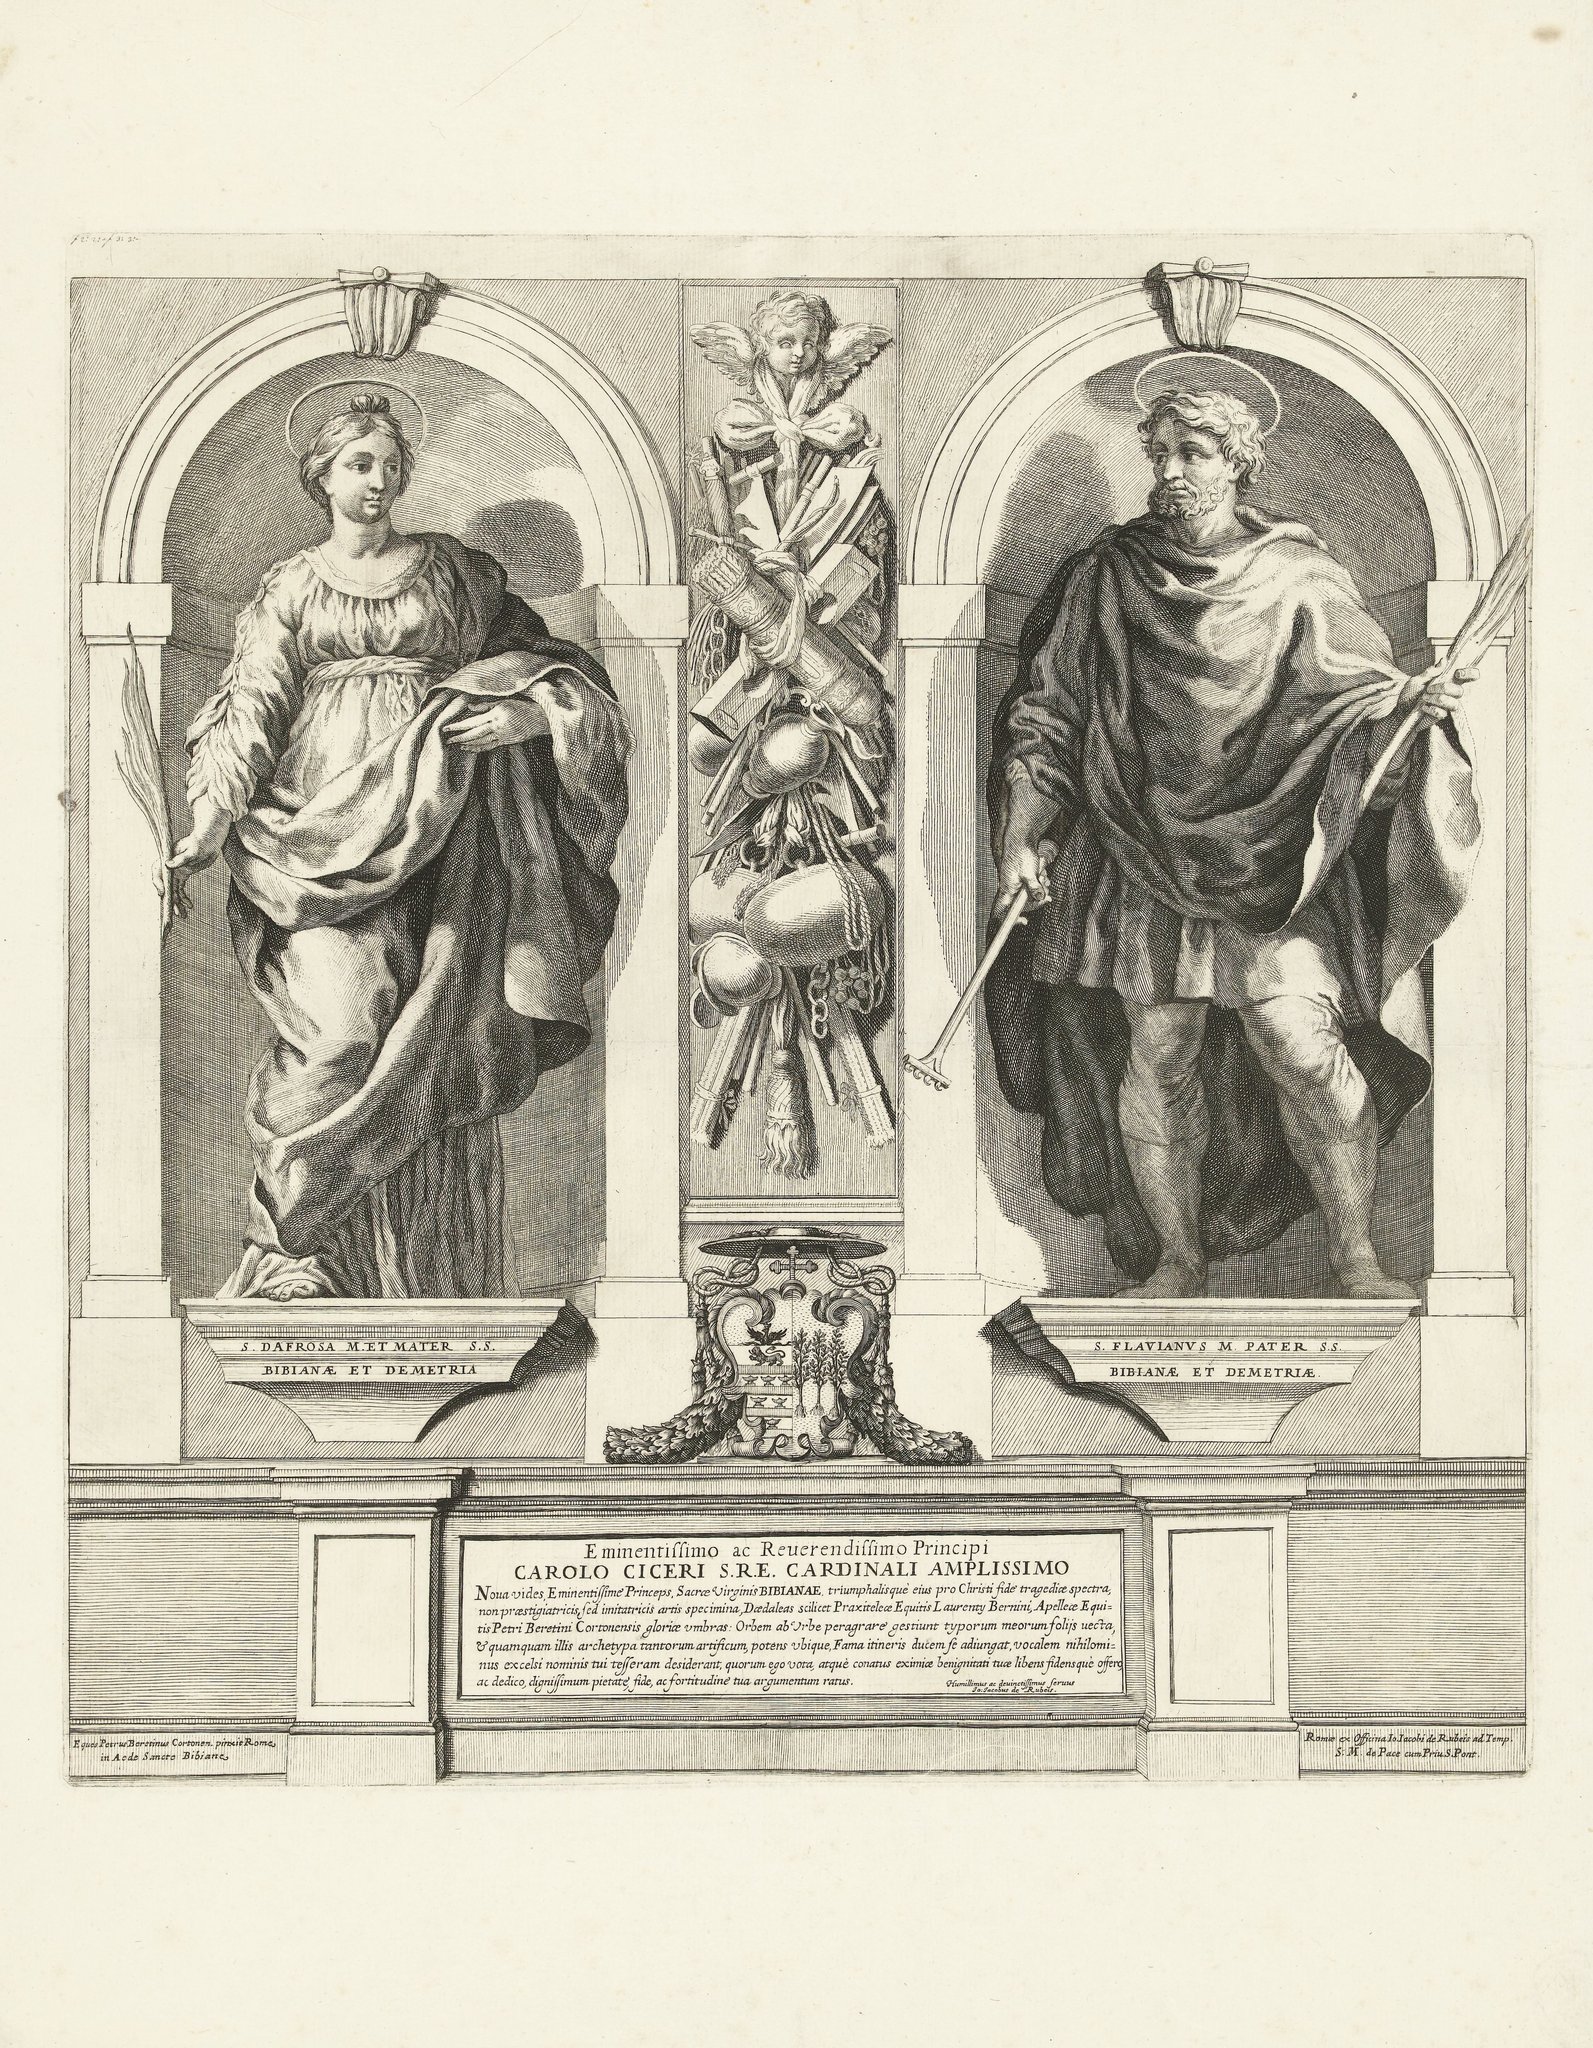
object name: print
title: Schilderingen en beelden uit de kerk Santa Bibiana in Rome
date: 1685-1691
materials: paper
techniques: engraving, etching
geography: rome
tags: female saints (with name), piece of sculpture, reproduction of a piece of sculpture, parents (first degree family relationships)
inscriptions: collector's mark: Lugt 240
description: De beelden van de ouders van Bibiana en haar zus Demetria in twee nissen in een muur geplaatst. Links Dafrosa de moeder van Bibiana, rechts haar vader Flavianus. Beiden werden op geheis van de Romeinse gouverneur Apronianus vermoord.